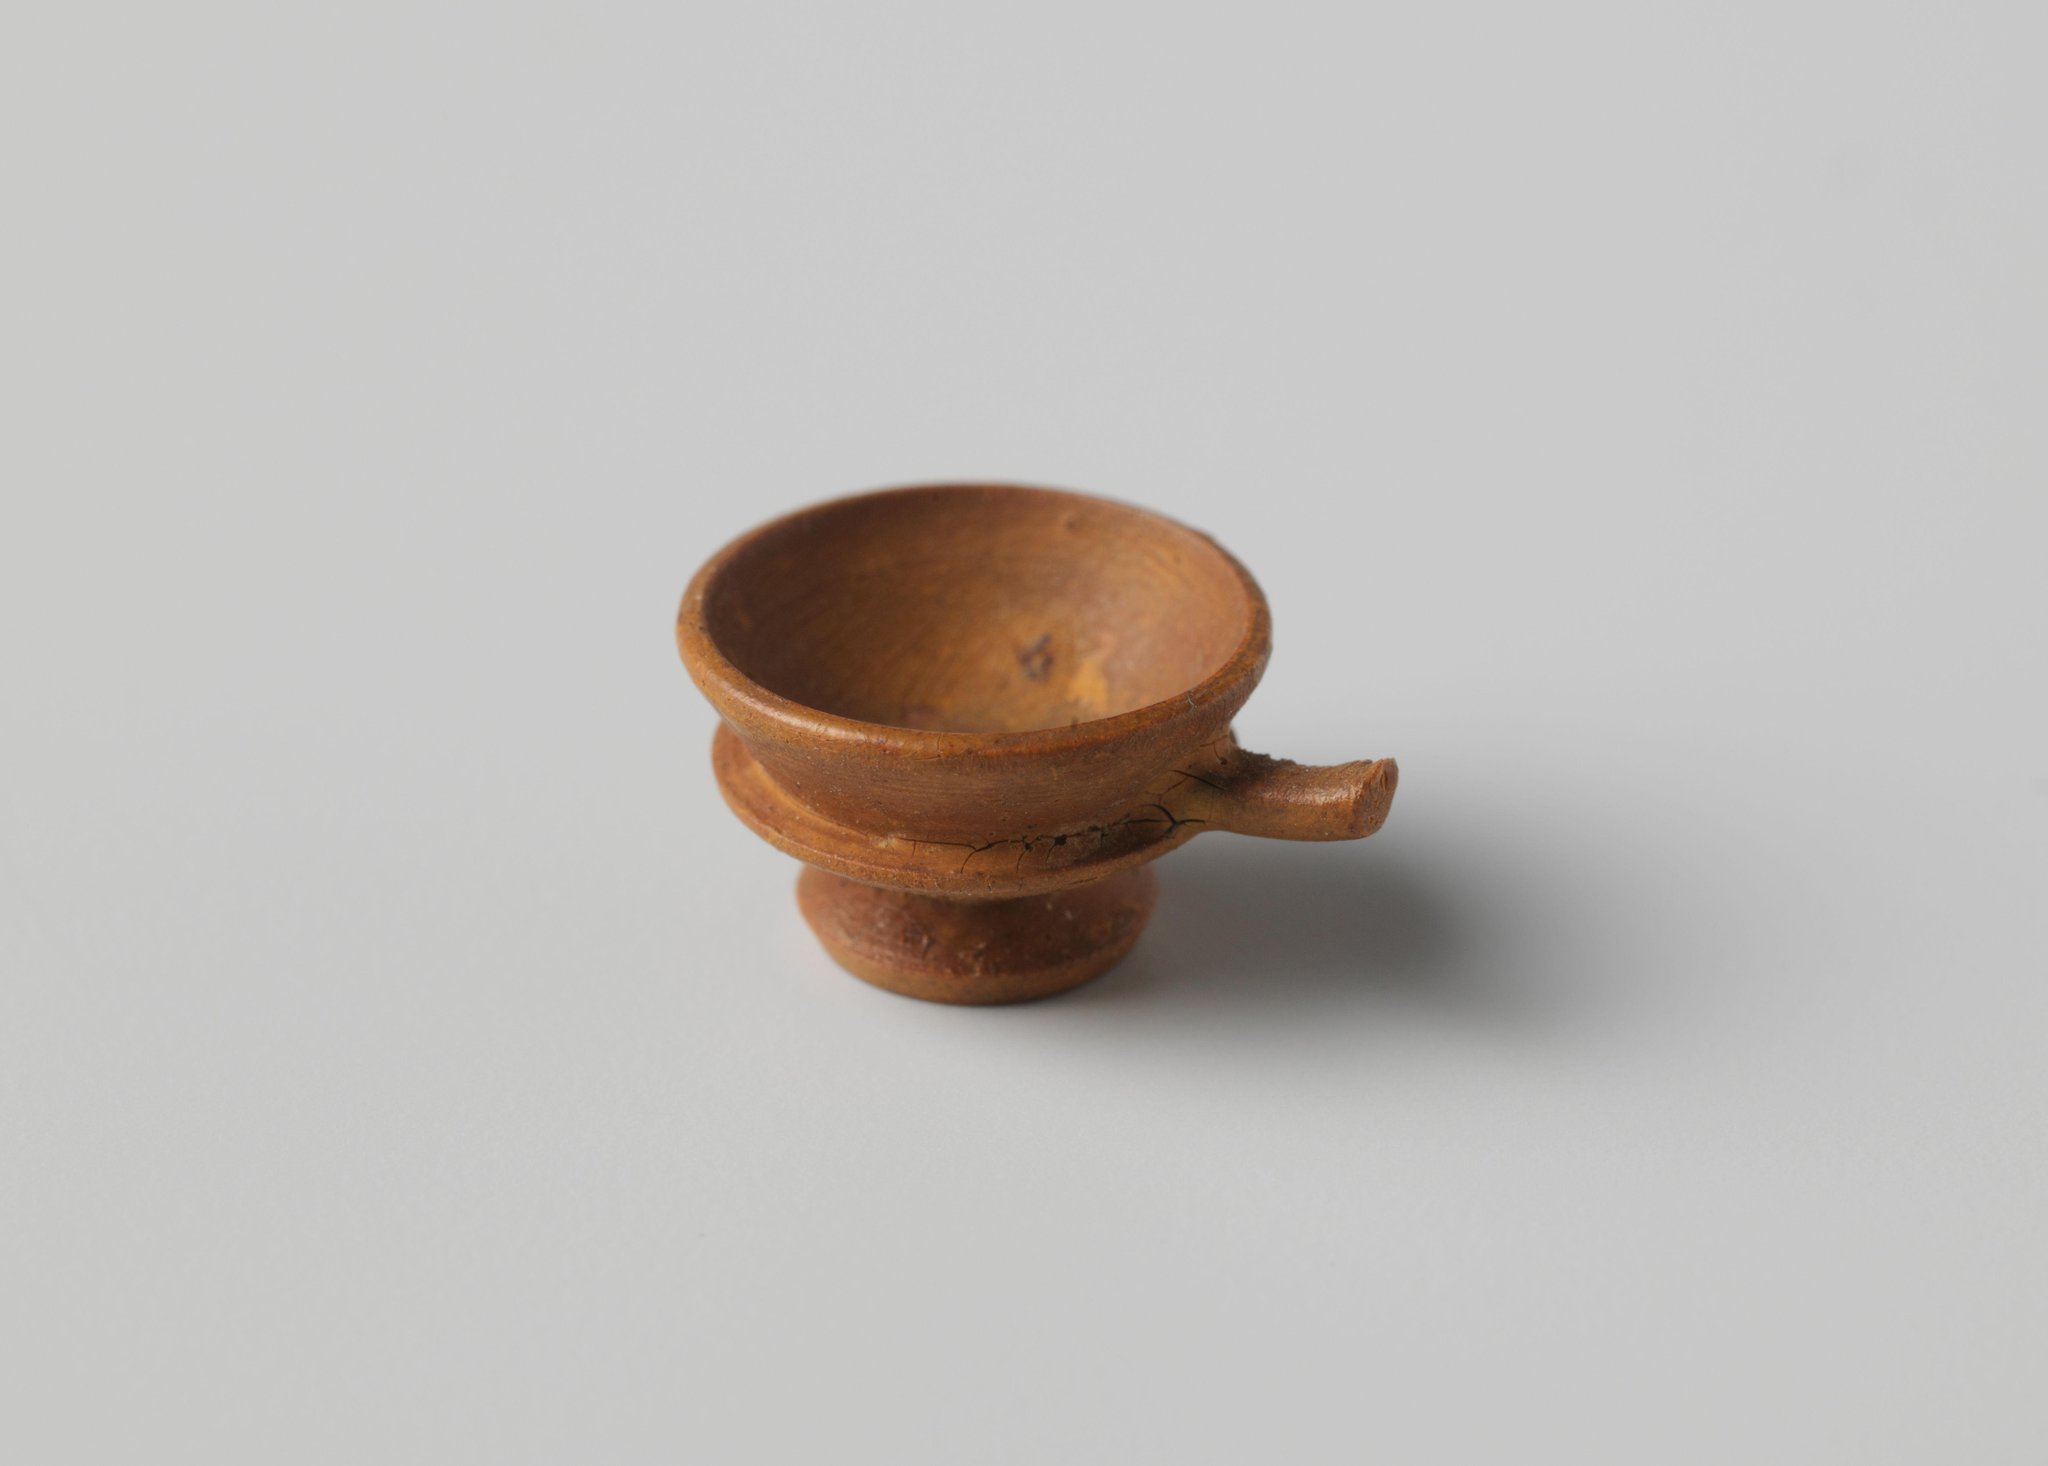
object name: bowl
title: Steelkom op voet van gedraaid hout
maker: Anonymous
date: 1675-1700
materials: wood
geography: amsterdam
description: Steelkom met korte steel op voet, gedraaid van esdoornhout.